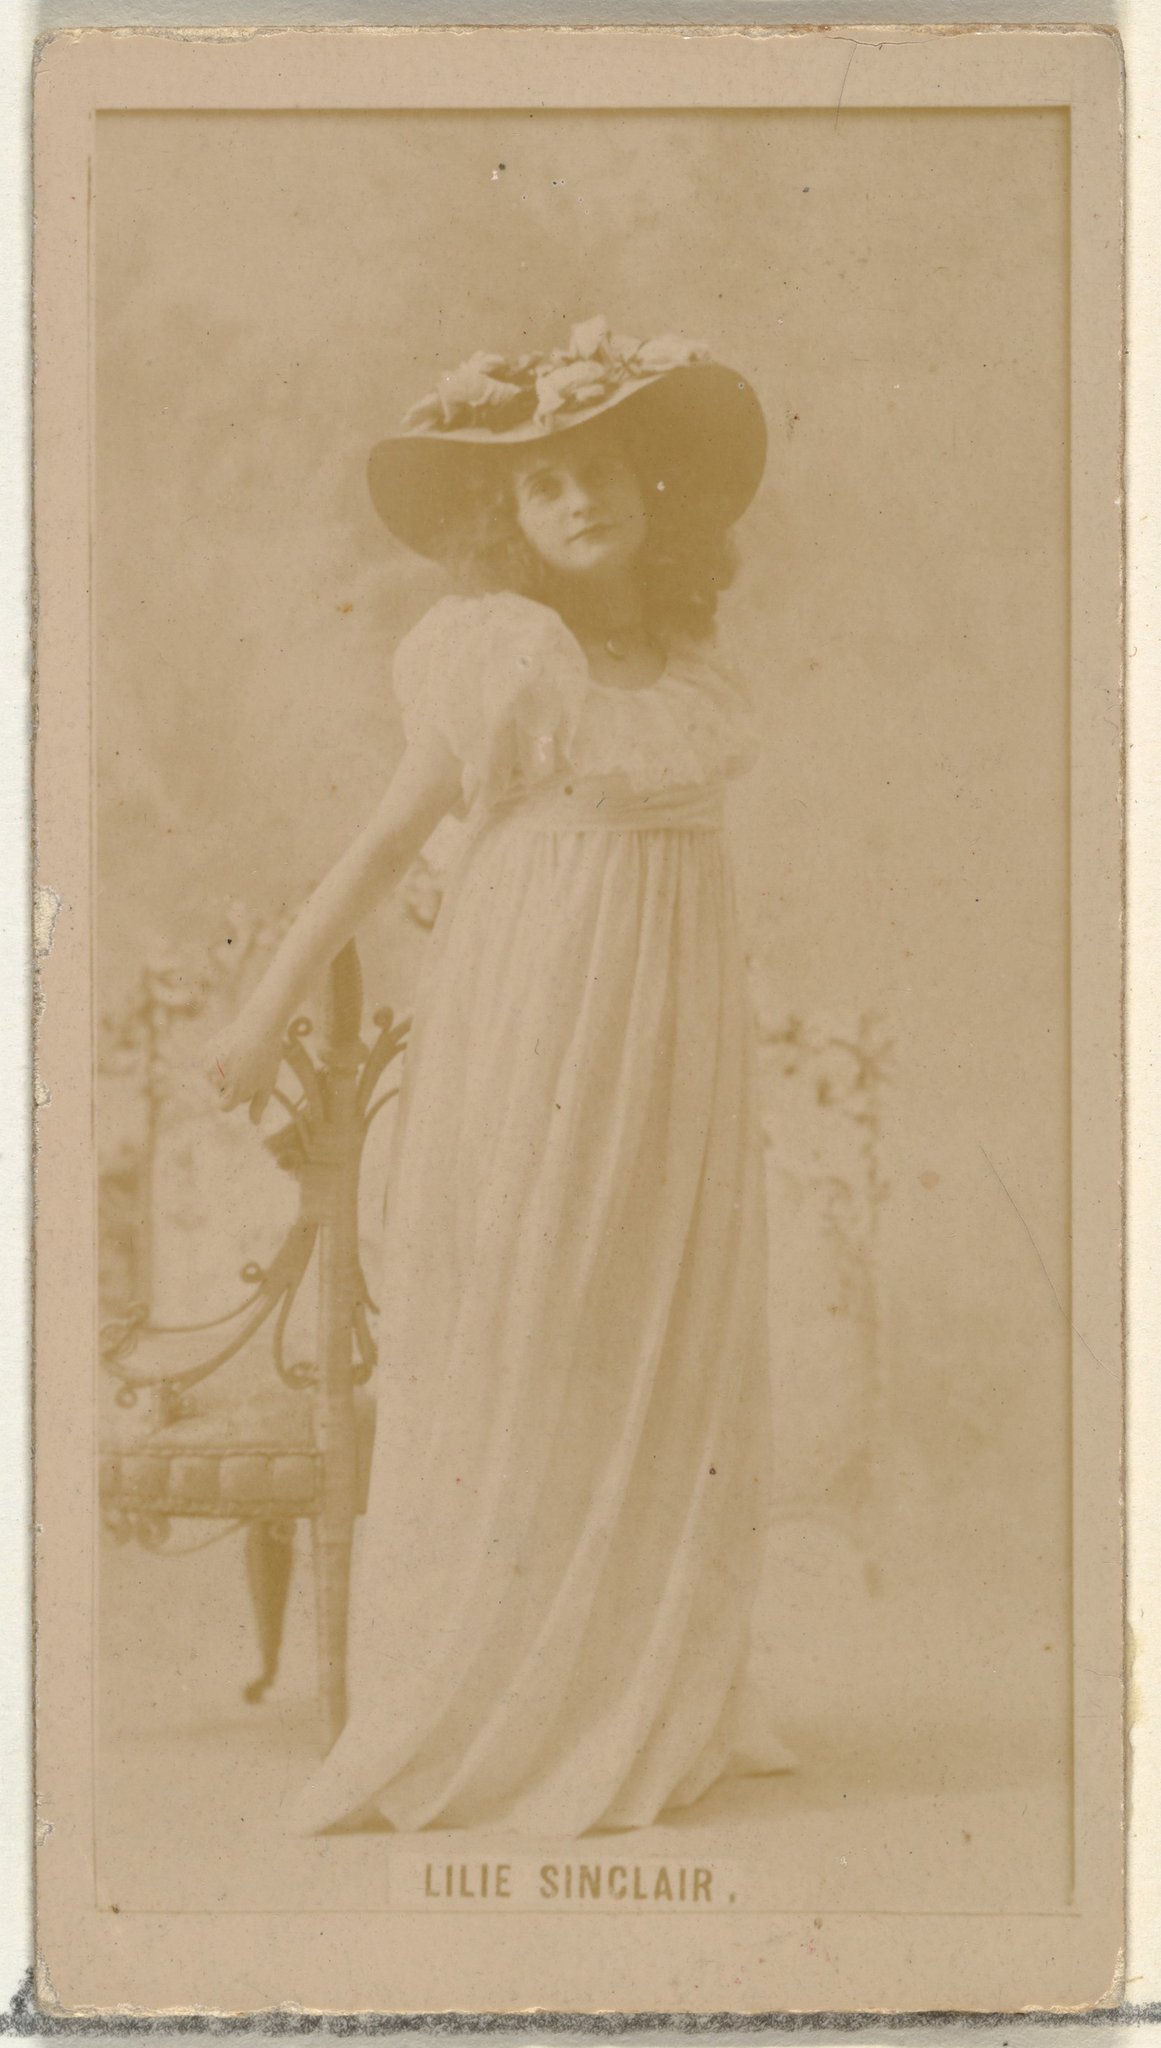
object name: photograph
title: Lilie Sinclair, from the Actors and Actresses series (N145-8) issued by Duke Sons & Co. to promote Duke Cigarettes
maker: w. duke, sons & co.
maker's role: publisher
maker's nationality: american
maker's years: 1870-1920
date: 1891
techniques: albumen silver print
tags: portraits,women,actresses